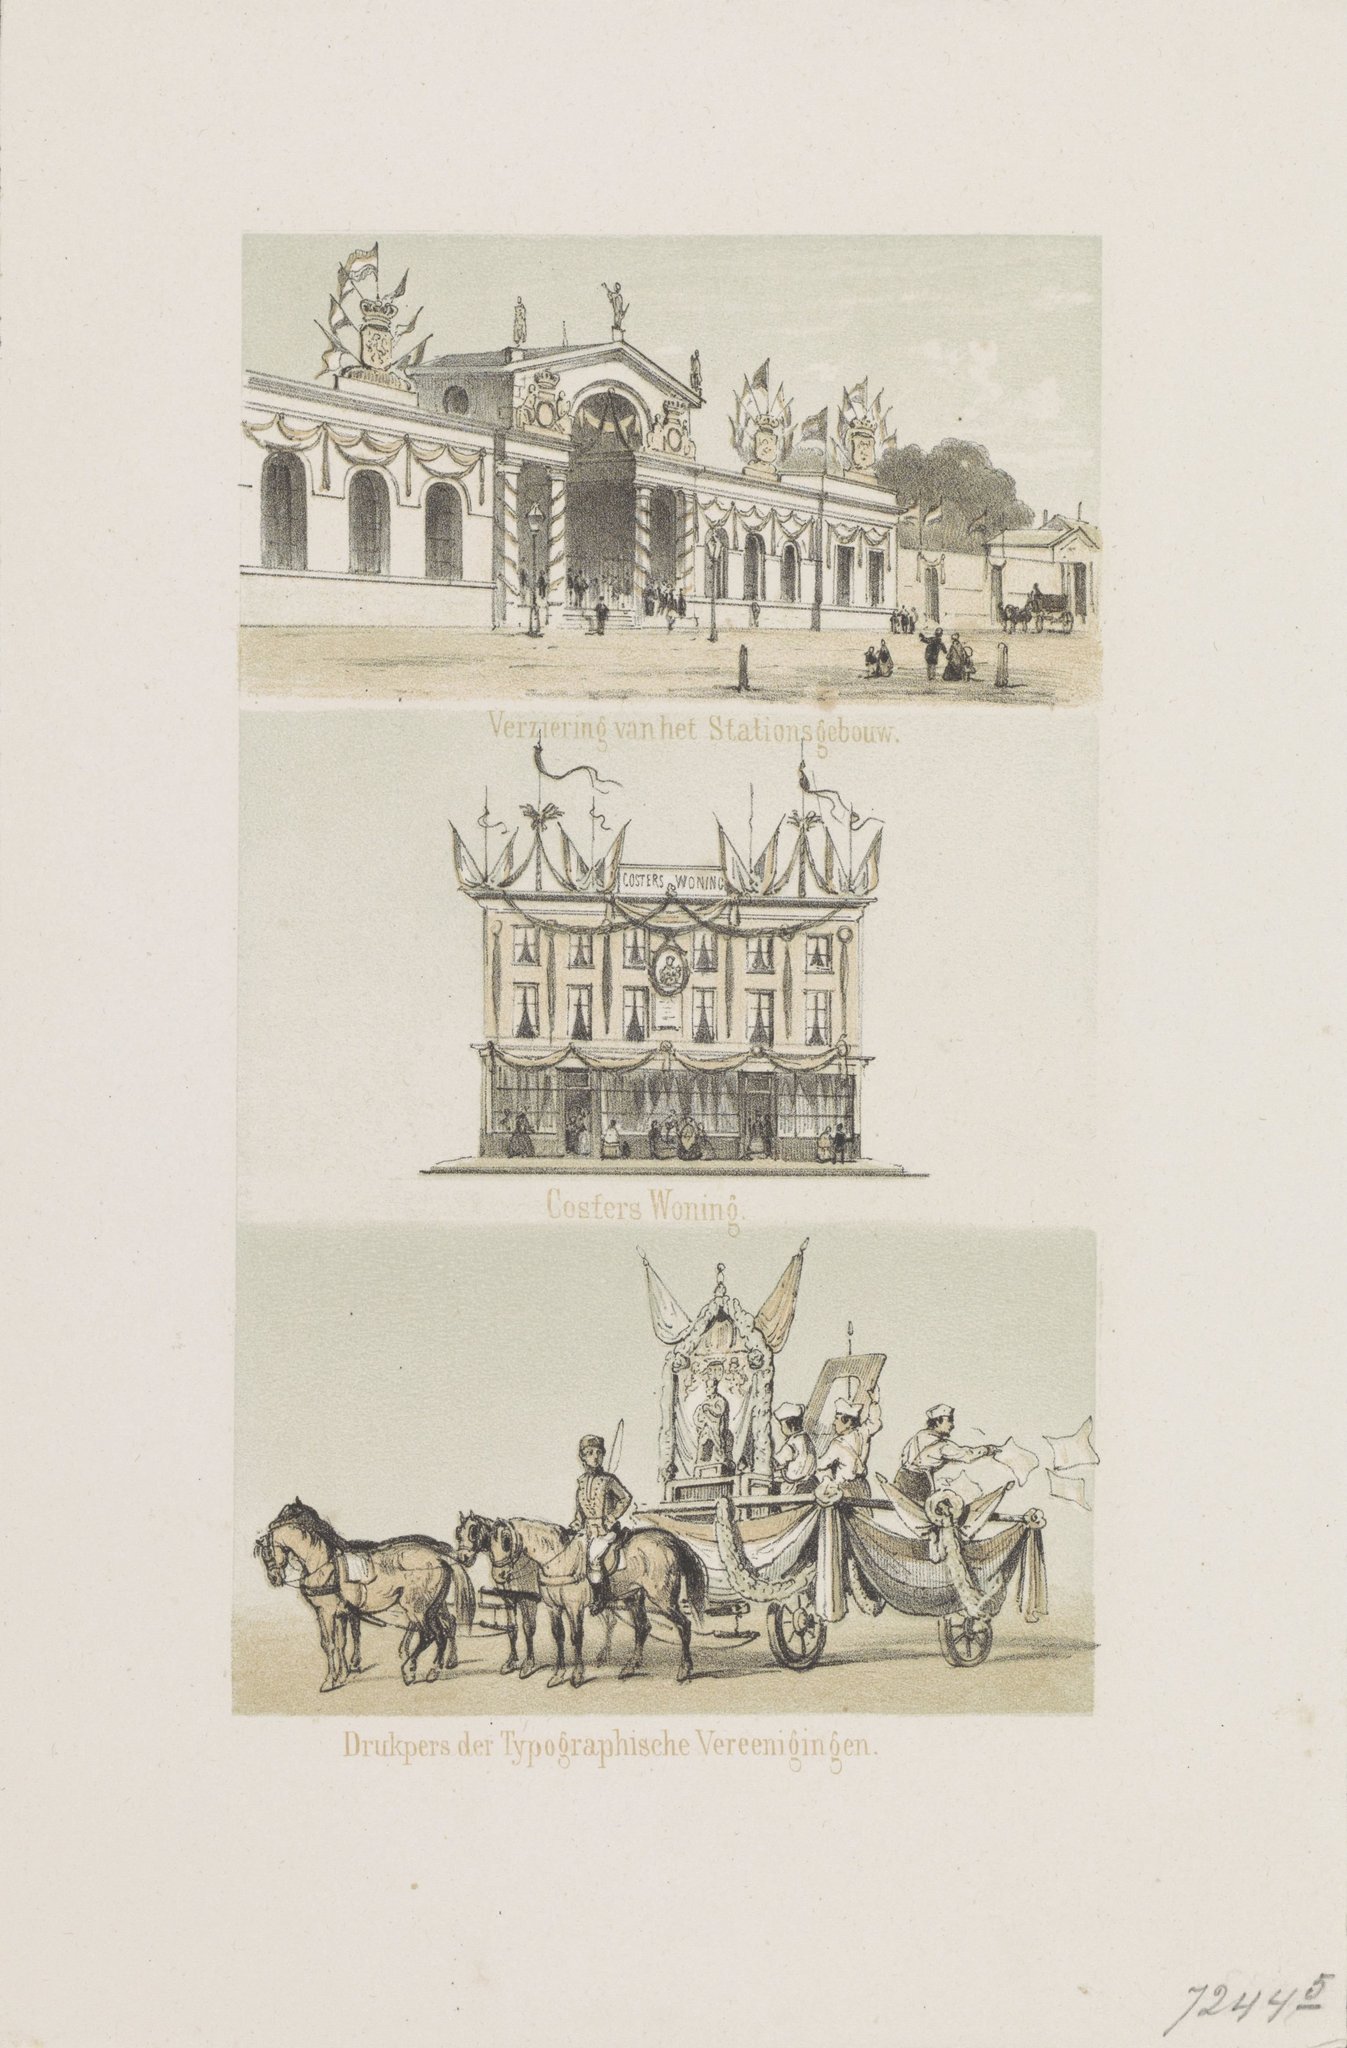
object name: print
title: Drie gezichten van het Costerfeest, 1856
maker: carel christiaan antony last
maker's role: print maker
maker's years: 1808-1876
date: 1856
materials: paper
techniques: lithograph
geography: the hague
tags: haarlem, float ~ triumph, rejoicing on special occasions (+ festive decoration ~ festive activities), printing press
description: Drie gezichten van het versierde treinstation van Haarlem en van 'Costers Woning' en een praalwagen met een drukpers. Onderdeel van een serie van zes platen van feestelijkheden rondom de onthulling van het standbeeld van Laurens Coster op de Grote Markt te Haarlem, 15-17 juli 1856.